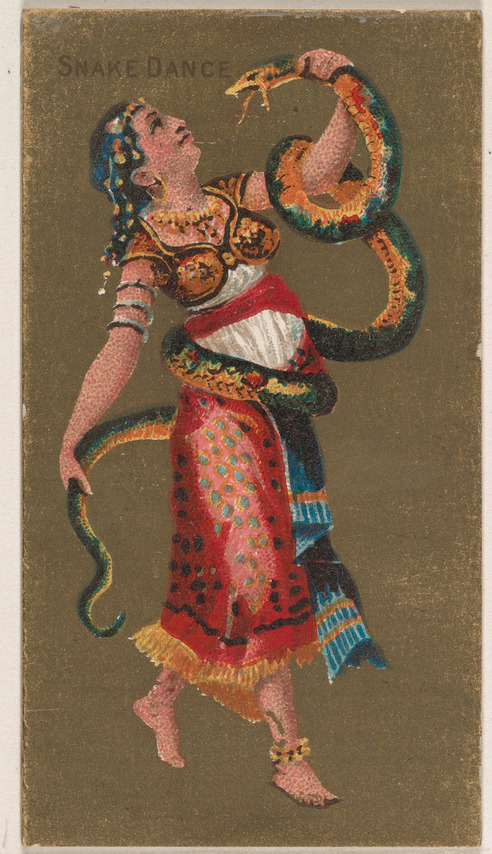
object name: print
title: Snake Dance, from National Dances (N225, Type 2) issued by Kinney Bros.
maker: kinney brothers tobacco company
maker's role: publisher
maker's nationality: american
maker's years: 1869-2011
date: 1889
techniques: color lithograph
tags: profiles,women,snakes,dancers